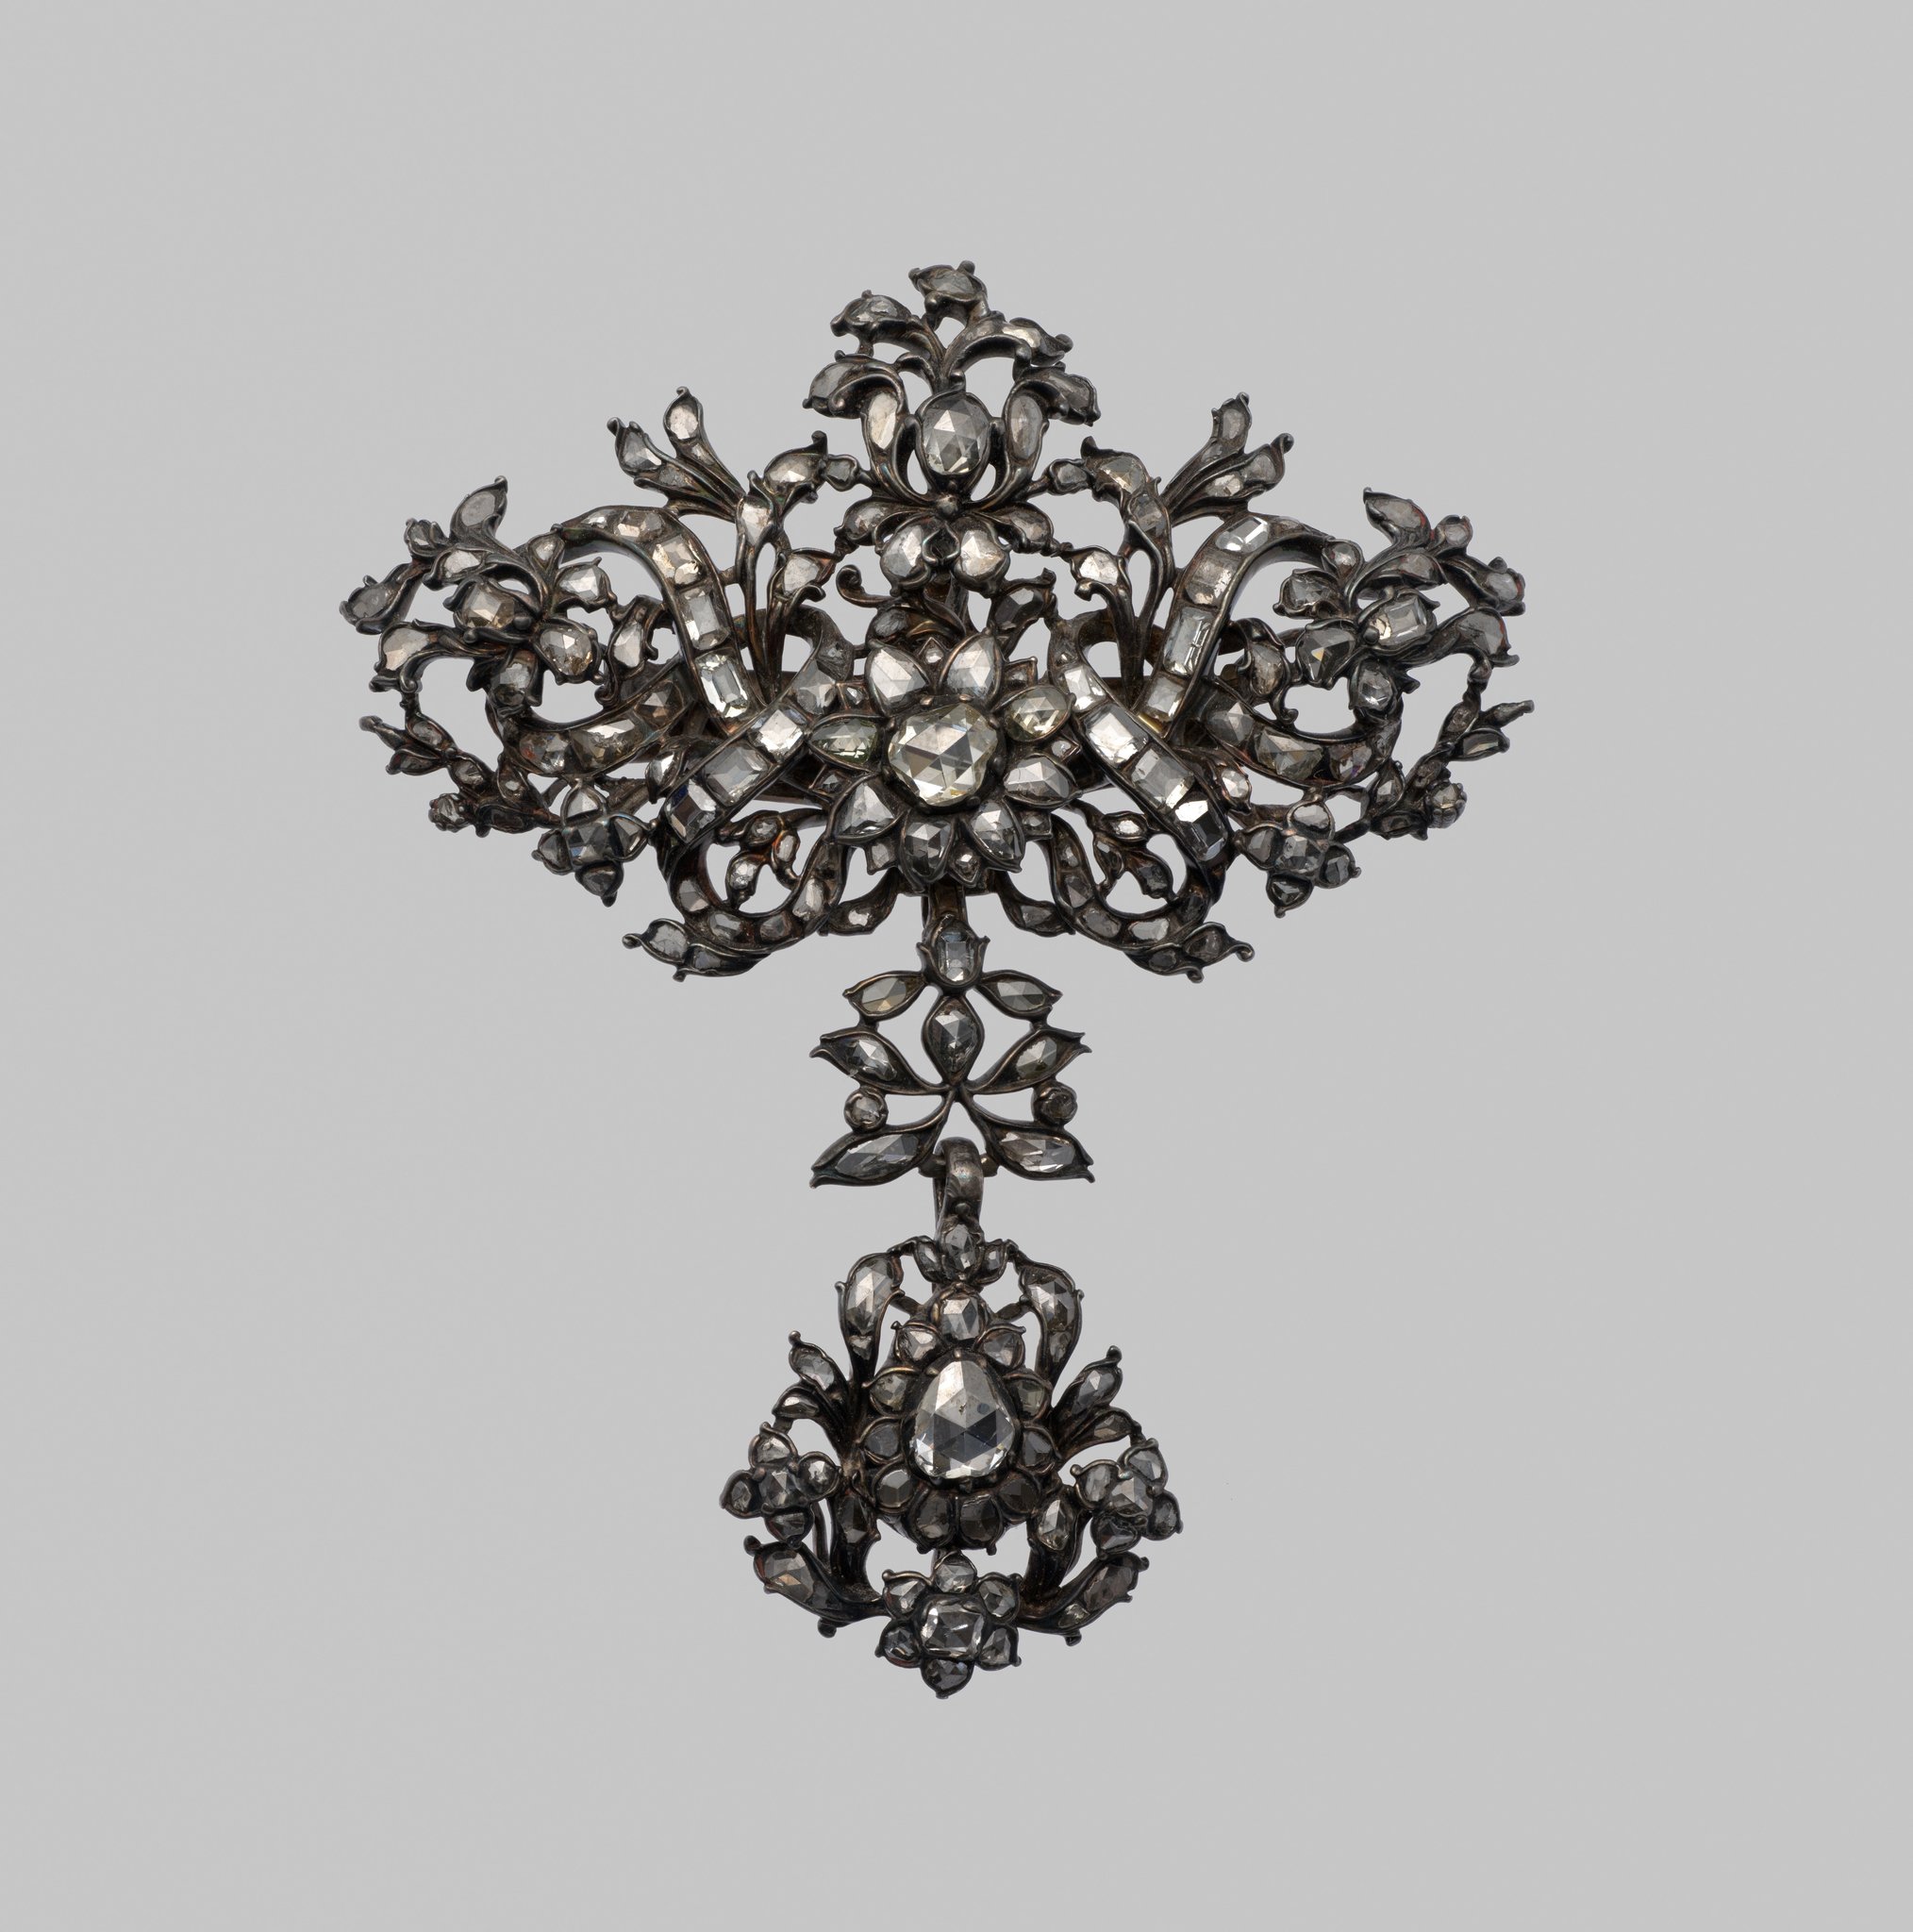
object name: brooch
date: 1701-1733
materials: diamond, silver